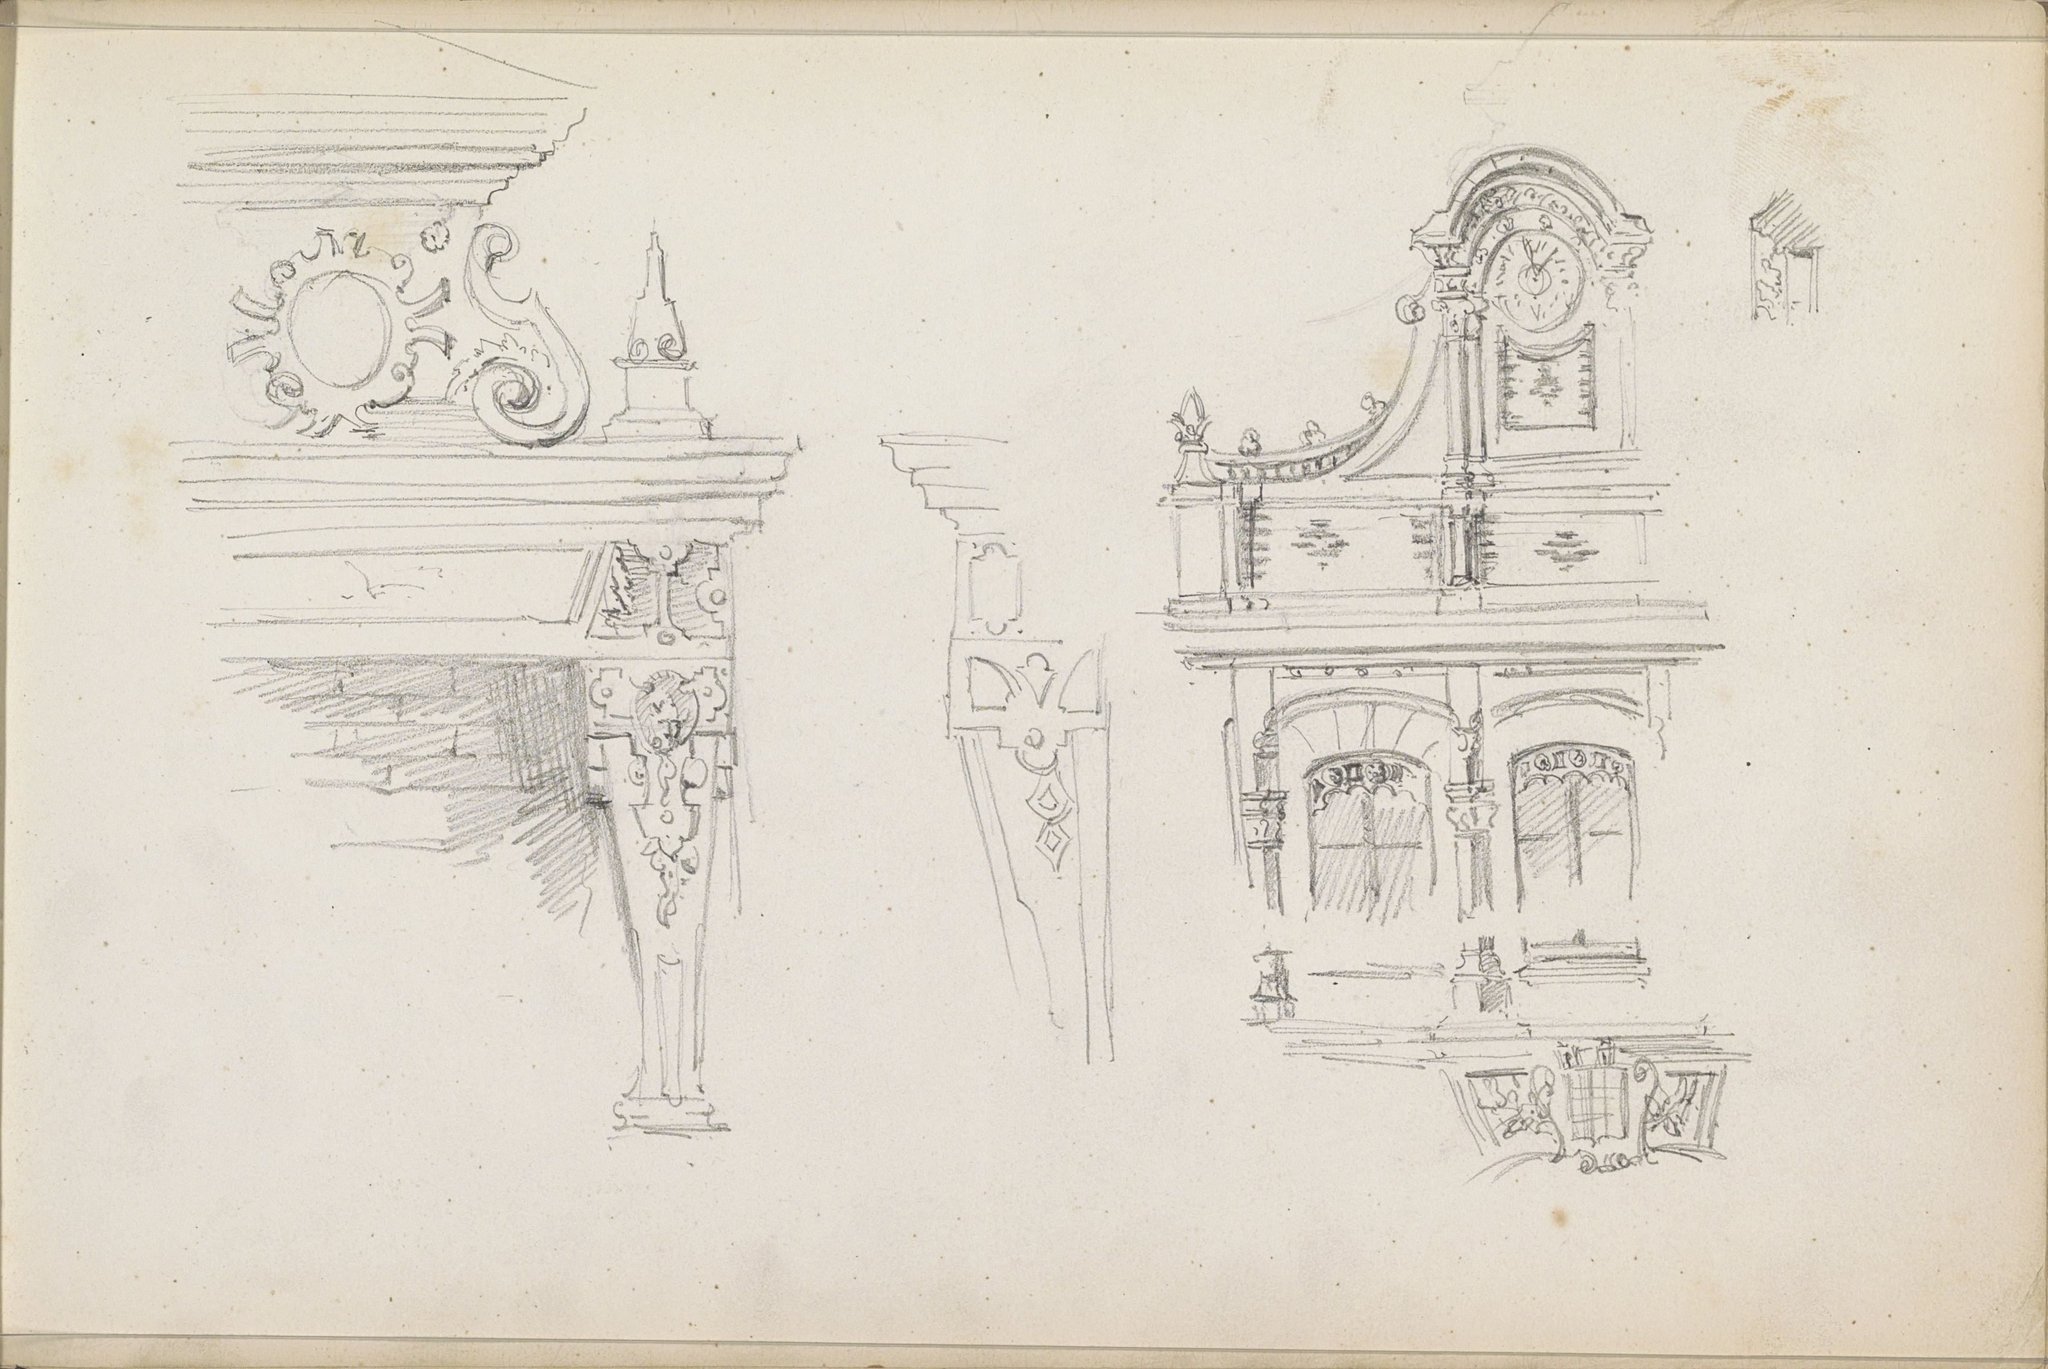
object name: sketchbook leaf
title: Klokgevel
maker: isaac gosschalk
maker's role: draughtsman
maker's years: 1838-1907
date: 1862-1867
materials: paper, pencil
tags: exterior ~ representation of a building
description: Blad 32 recto uit een schetsboek met 58 bladen.